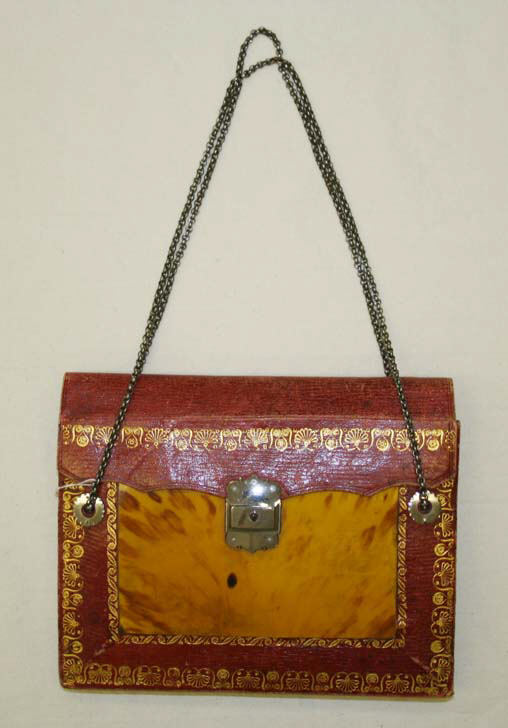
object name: purse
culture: european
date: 1800-1810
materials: leather, metal